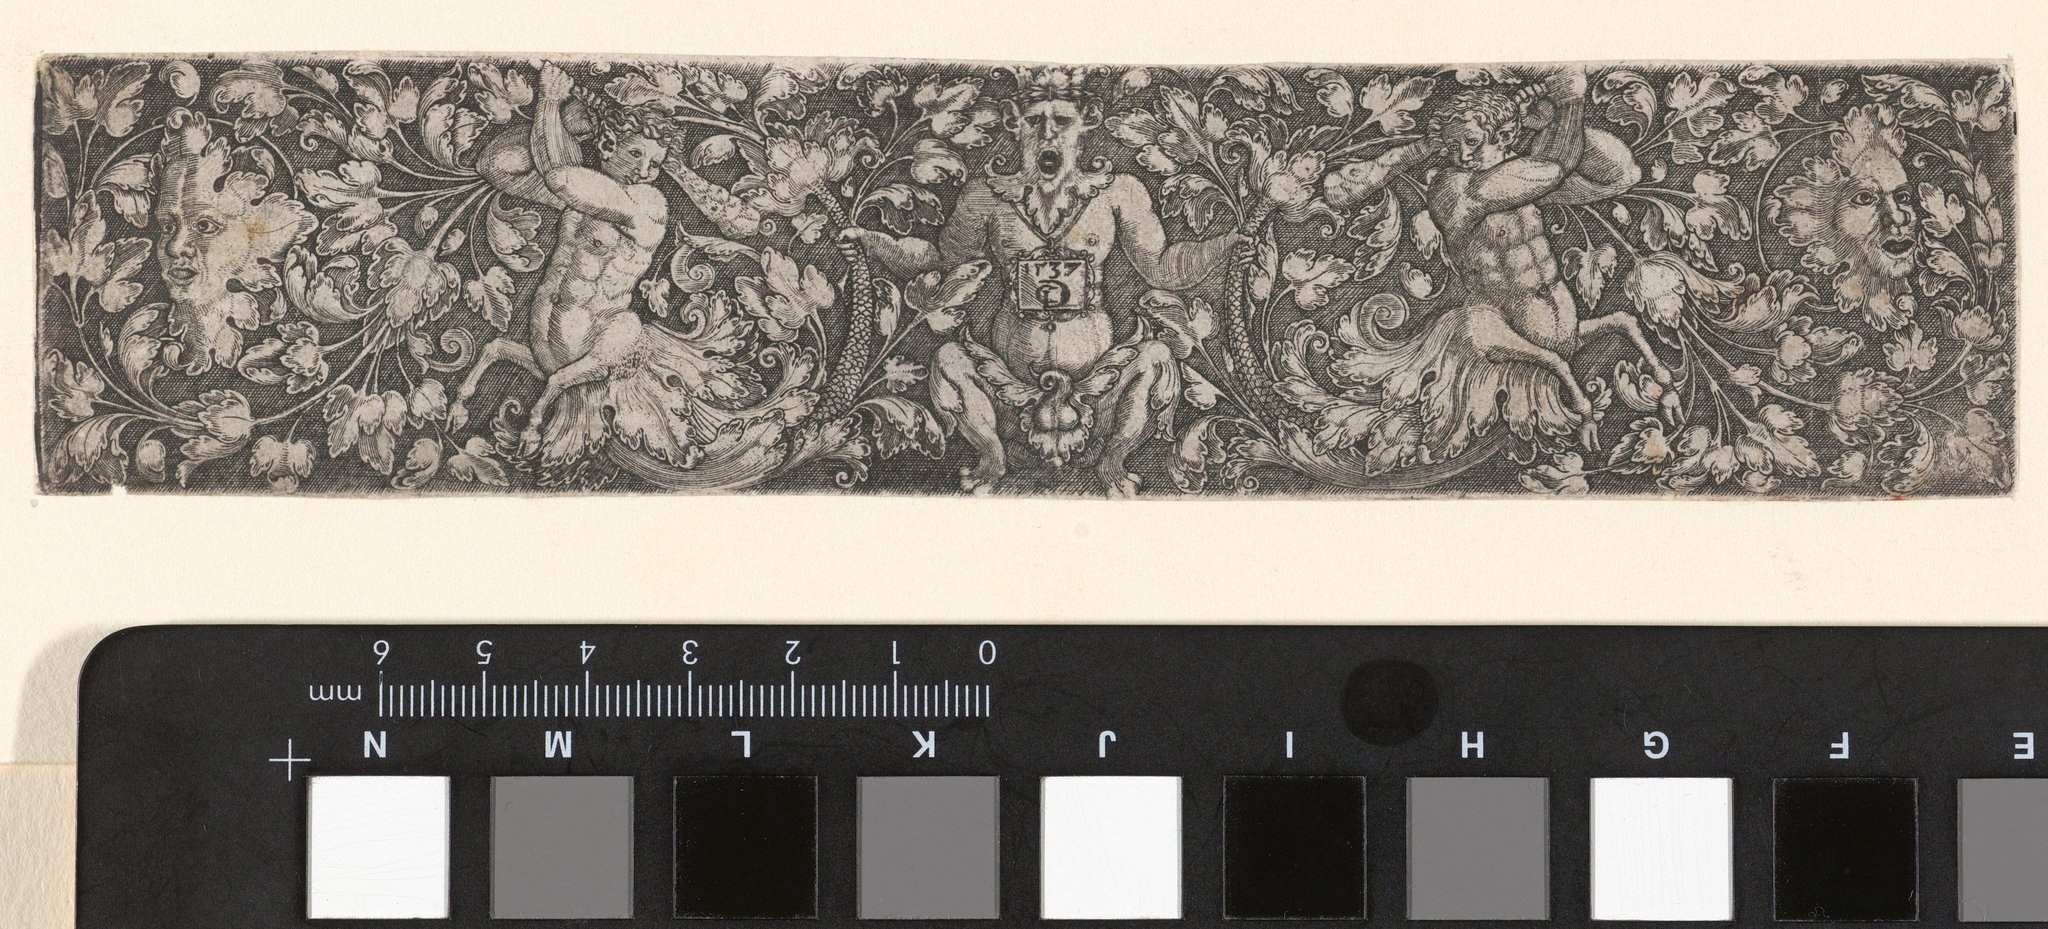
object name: ornament print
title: Fries met gehurkte sater tussen twee tritons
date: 1534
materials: paper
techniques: engraving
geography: germany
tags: triton(s), satyr(s) (in general)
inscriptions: collector's mark: Lugt 240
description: De sater houdt de staarten van de tritons in zijn handen, de tritons houden knotsen vast. Gearceerde achtergrond.